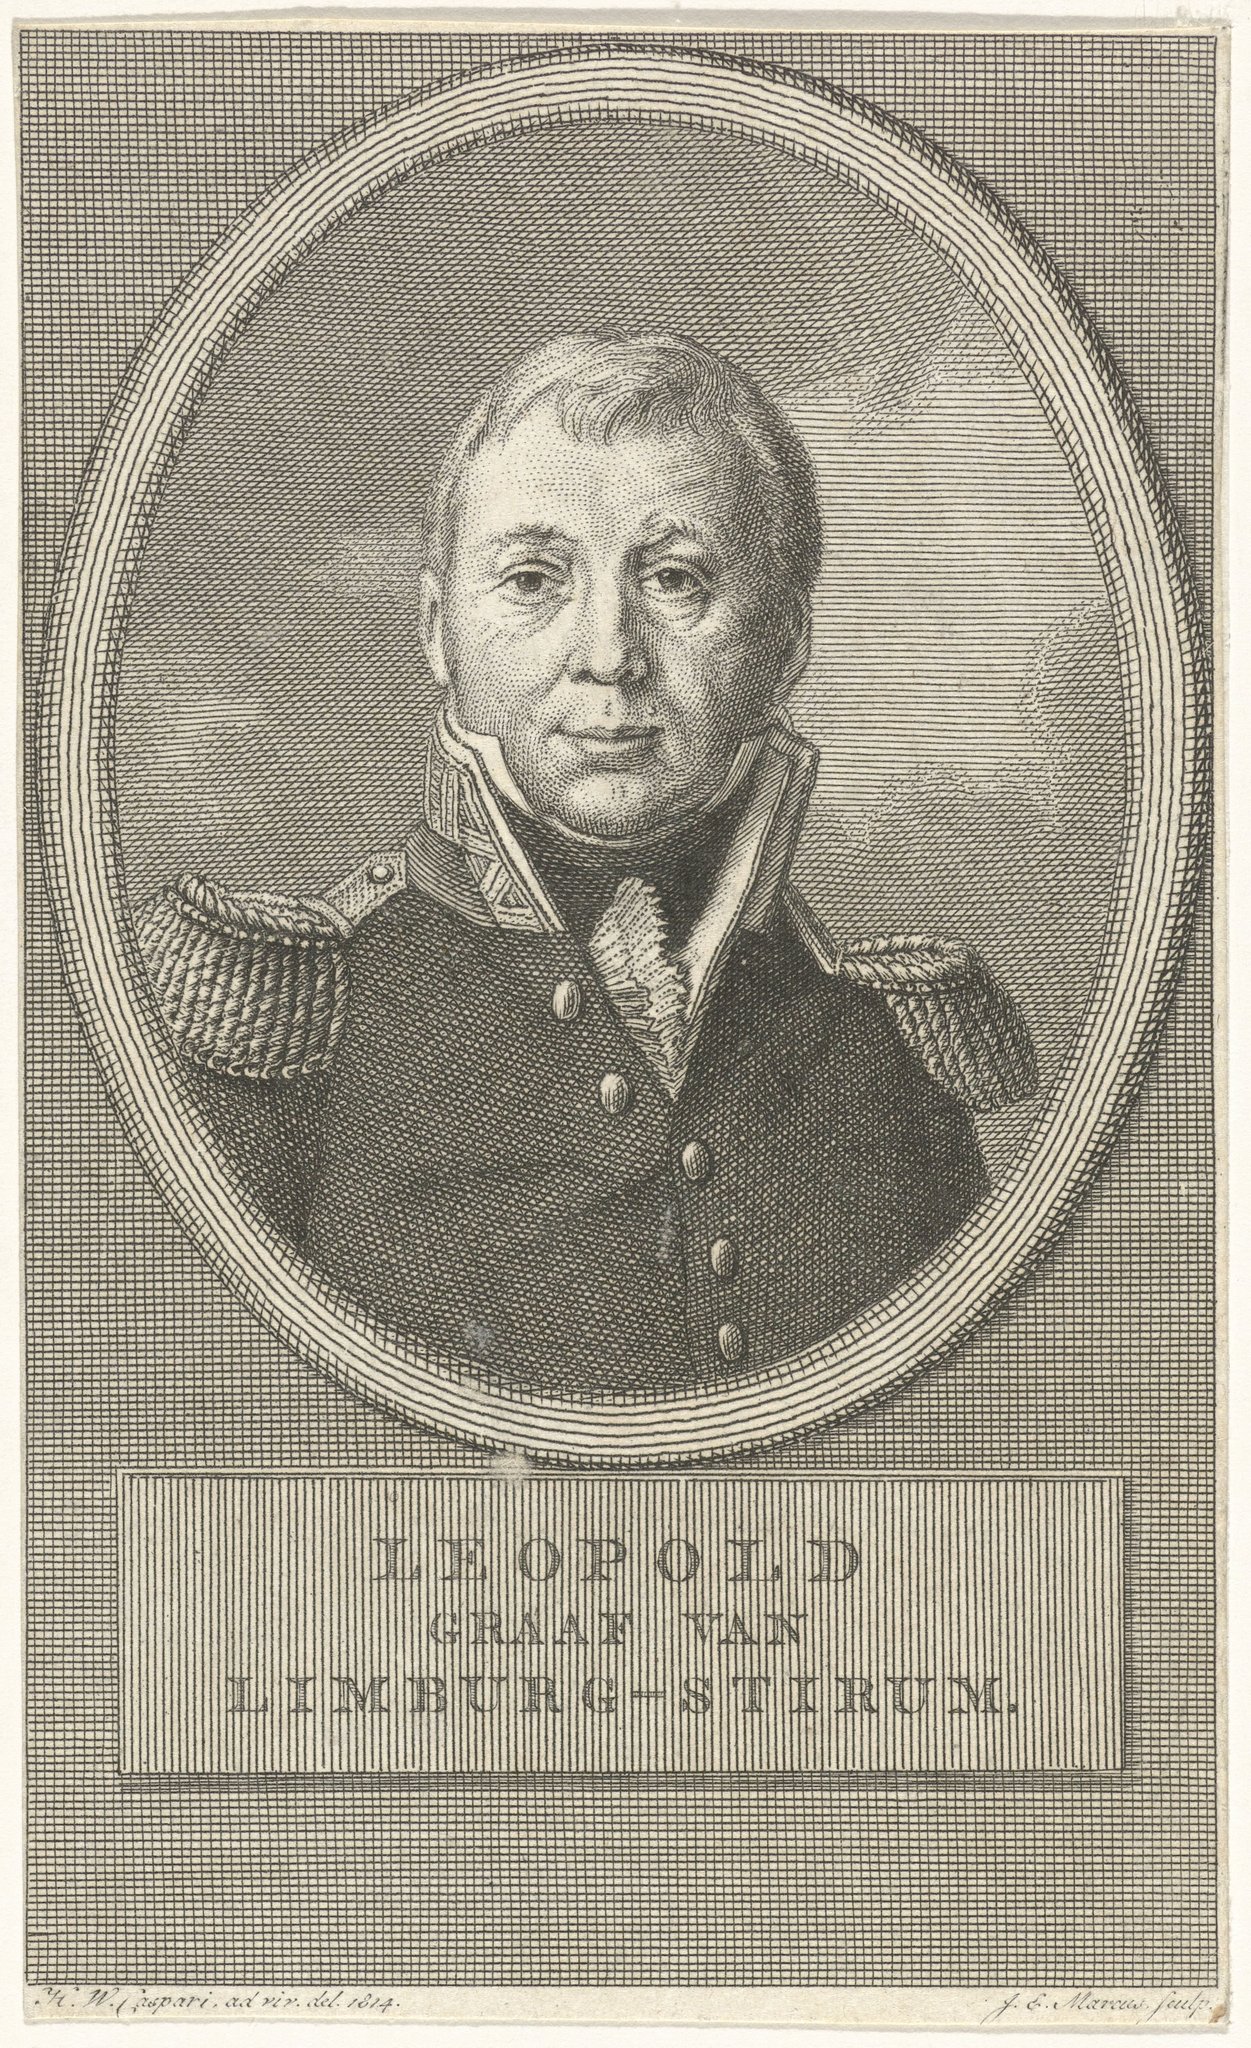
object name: print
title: Portret van Leopold graaf van Limburg Stirum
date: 1814-1817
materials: paper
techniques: engraving, etching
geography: amsterdam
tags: the hague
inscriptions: collector's mark: Lugt 2228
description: Prent ook gebruikt in: Herman Bosscha, Geschiedenis der Nederlandsche staatsomwenteling in 1813. 4 dln. Amsterdam: P. den Hengt en zn. en J. van der Hey, 1817.